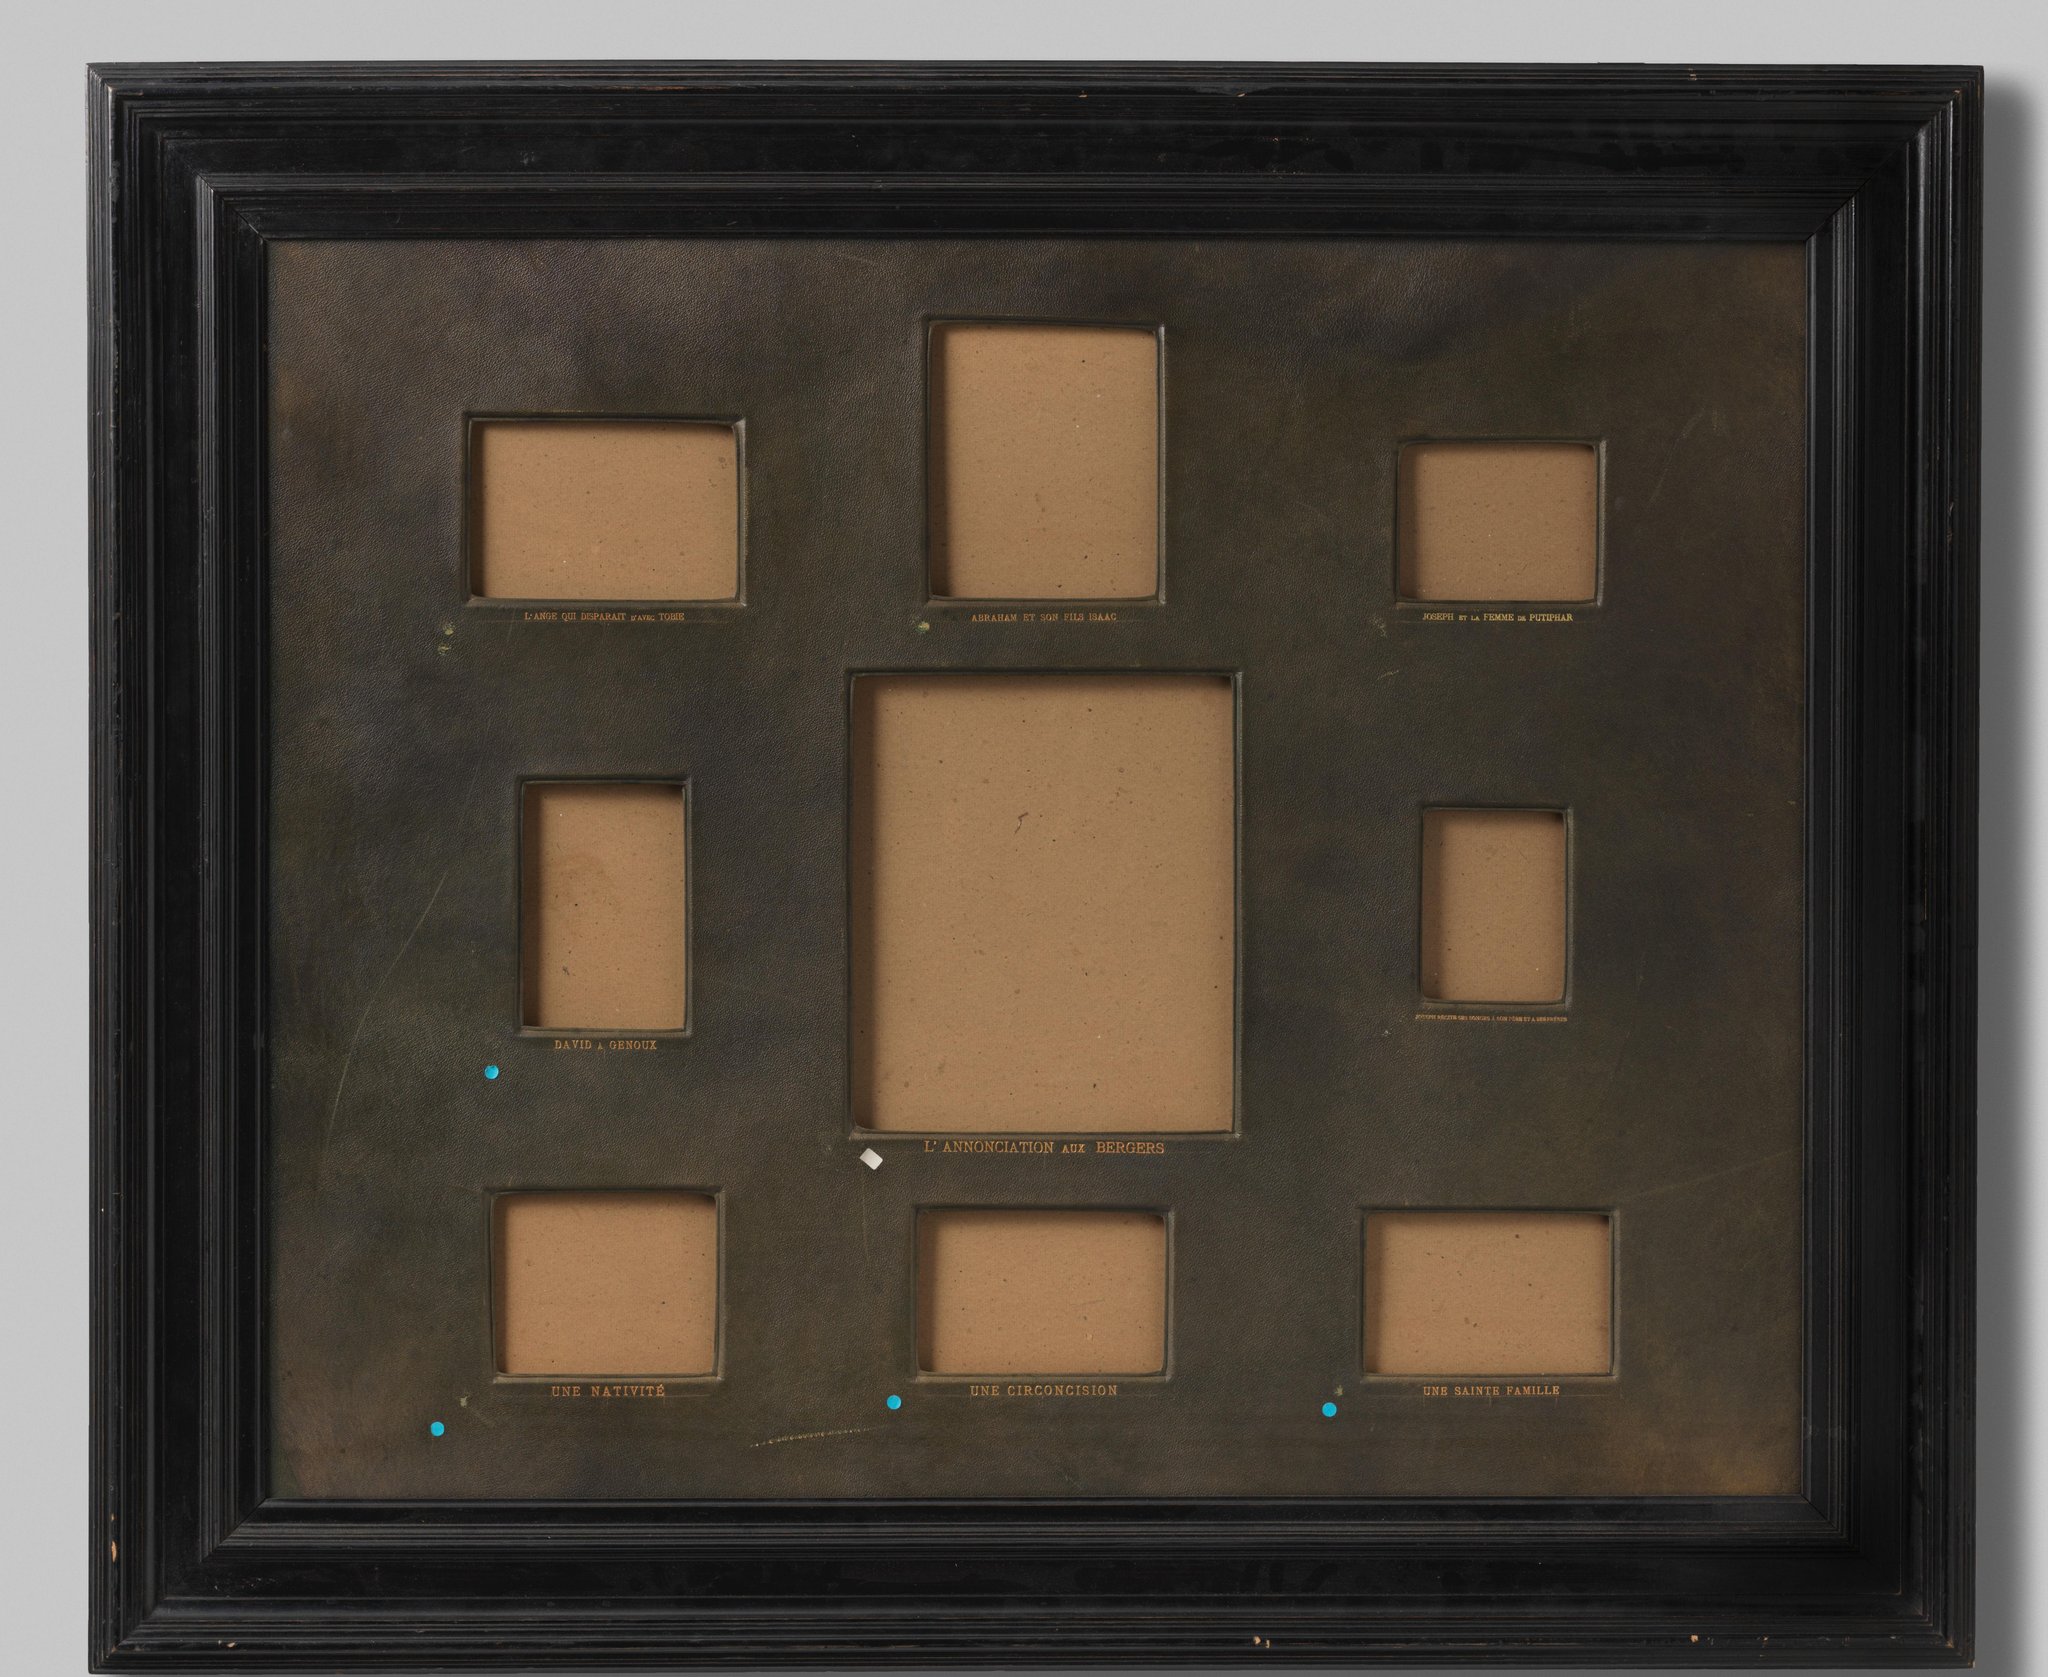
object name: frame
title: Zwarte geschilderde profiellijst met met leer beklede passe-partout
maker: Anonymous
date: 1995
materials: leather, paint, wood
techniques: painting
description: Lijst voor Rembrandt plaatjes, hoort bij RP-D-1995-7 .